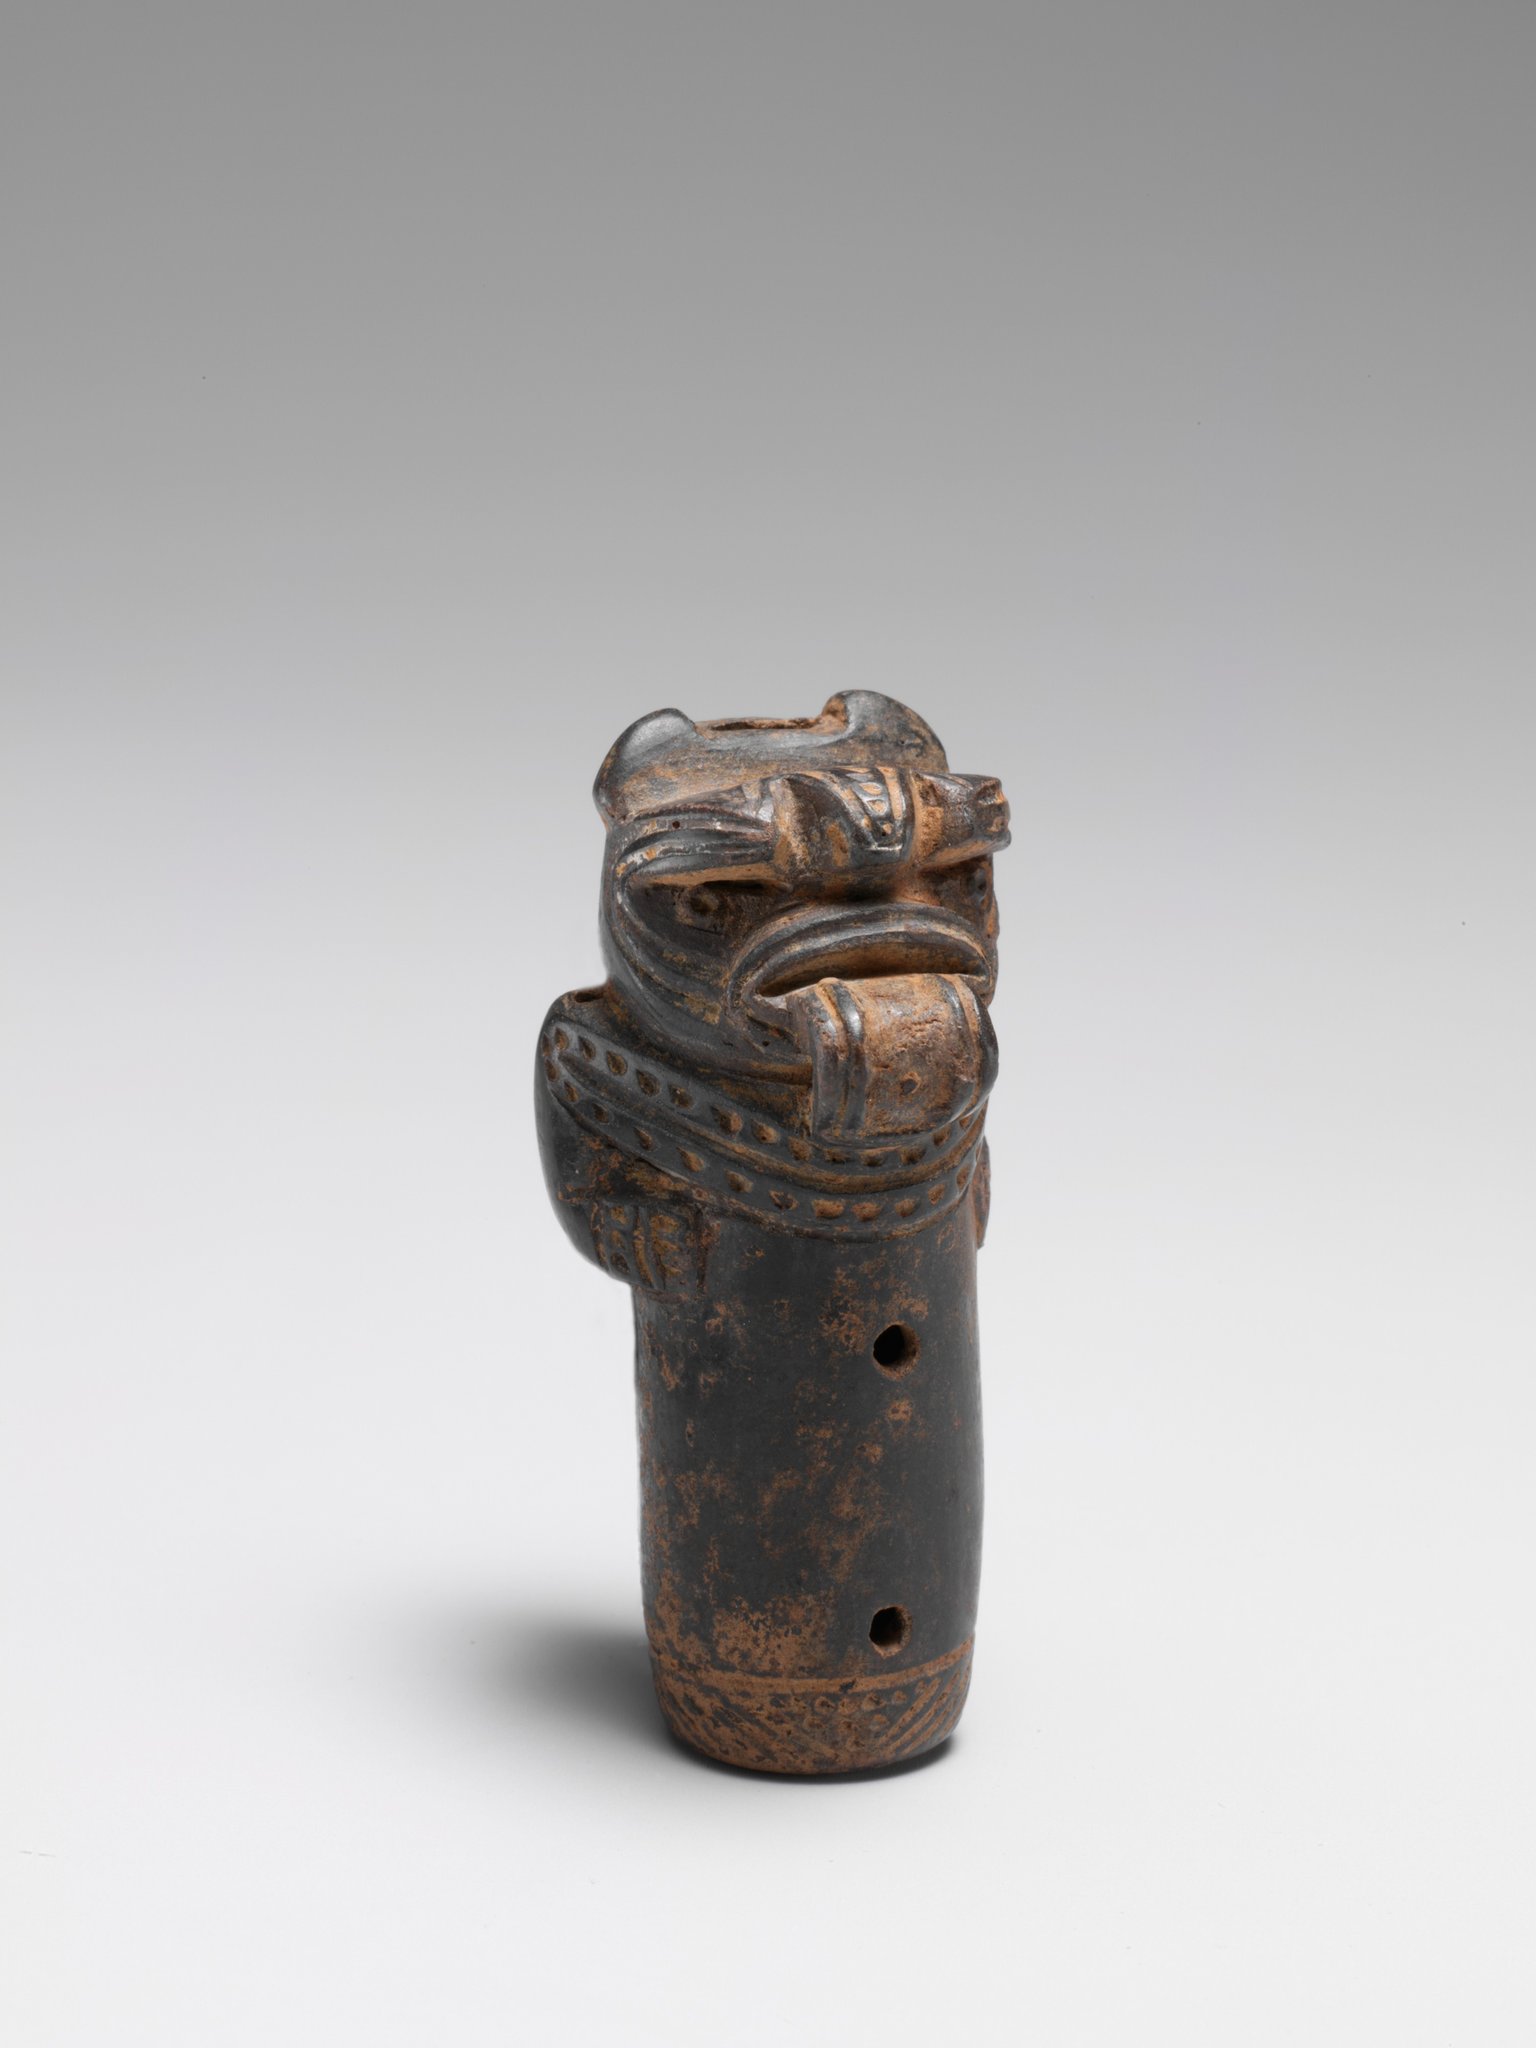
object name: flute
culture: tairona people or la aguja style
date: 1300-1500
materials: ceramic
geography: colombia